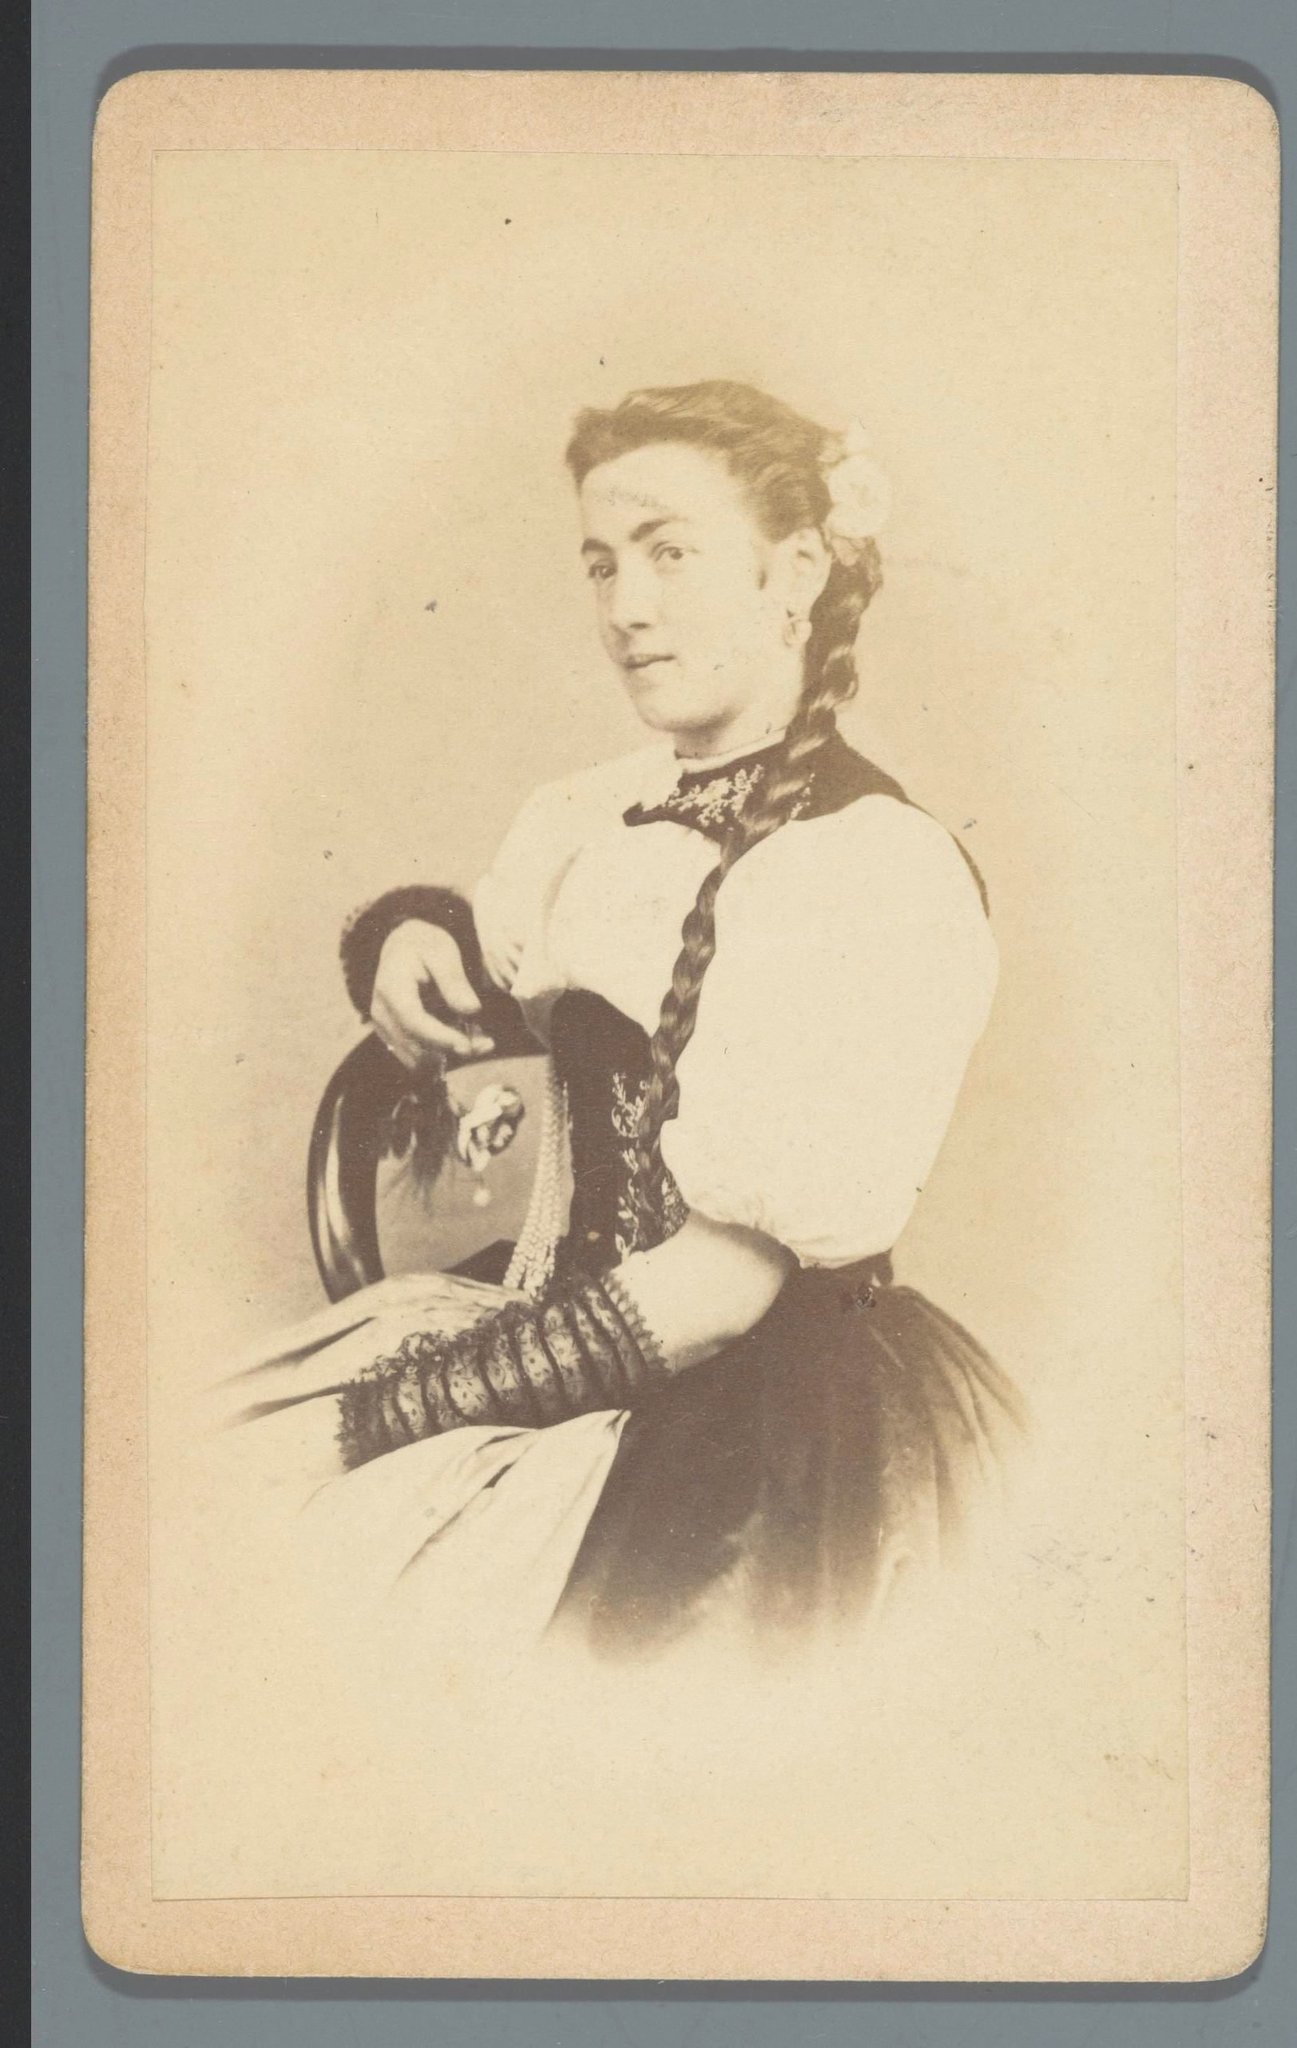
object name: photograph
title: Portret van een onbekende jonge vrouw in klederdracht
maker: heinrich fischer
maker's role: painter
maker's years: 1820-1886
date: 1855-1885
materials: cardboard, paper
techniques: albumen print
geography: lucerne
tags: adolescent, young woman, maiden, anonymous historical person portrayed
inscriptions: inscription: ‘H. Fischer/ Phot. Artist. Atelier/ Luzern’